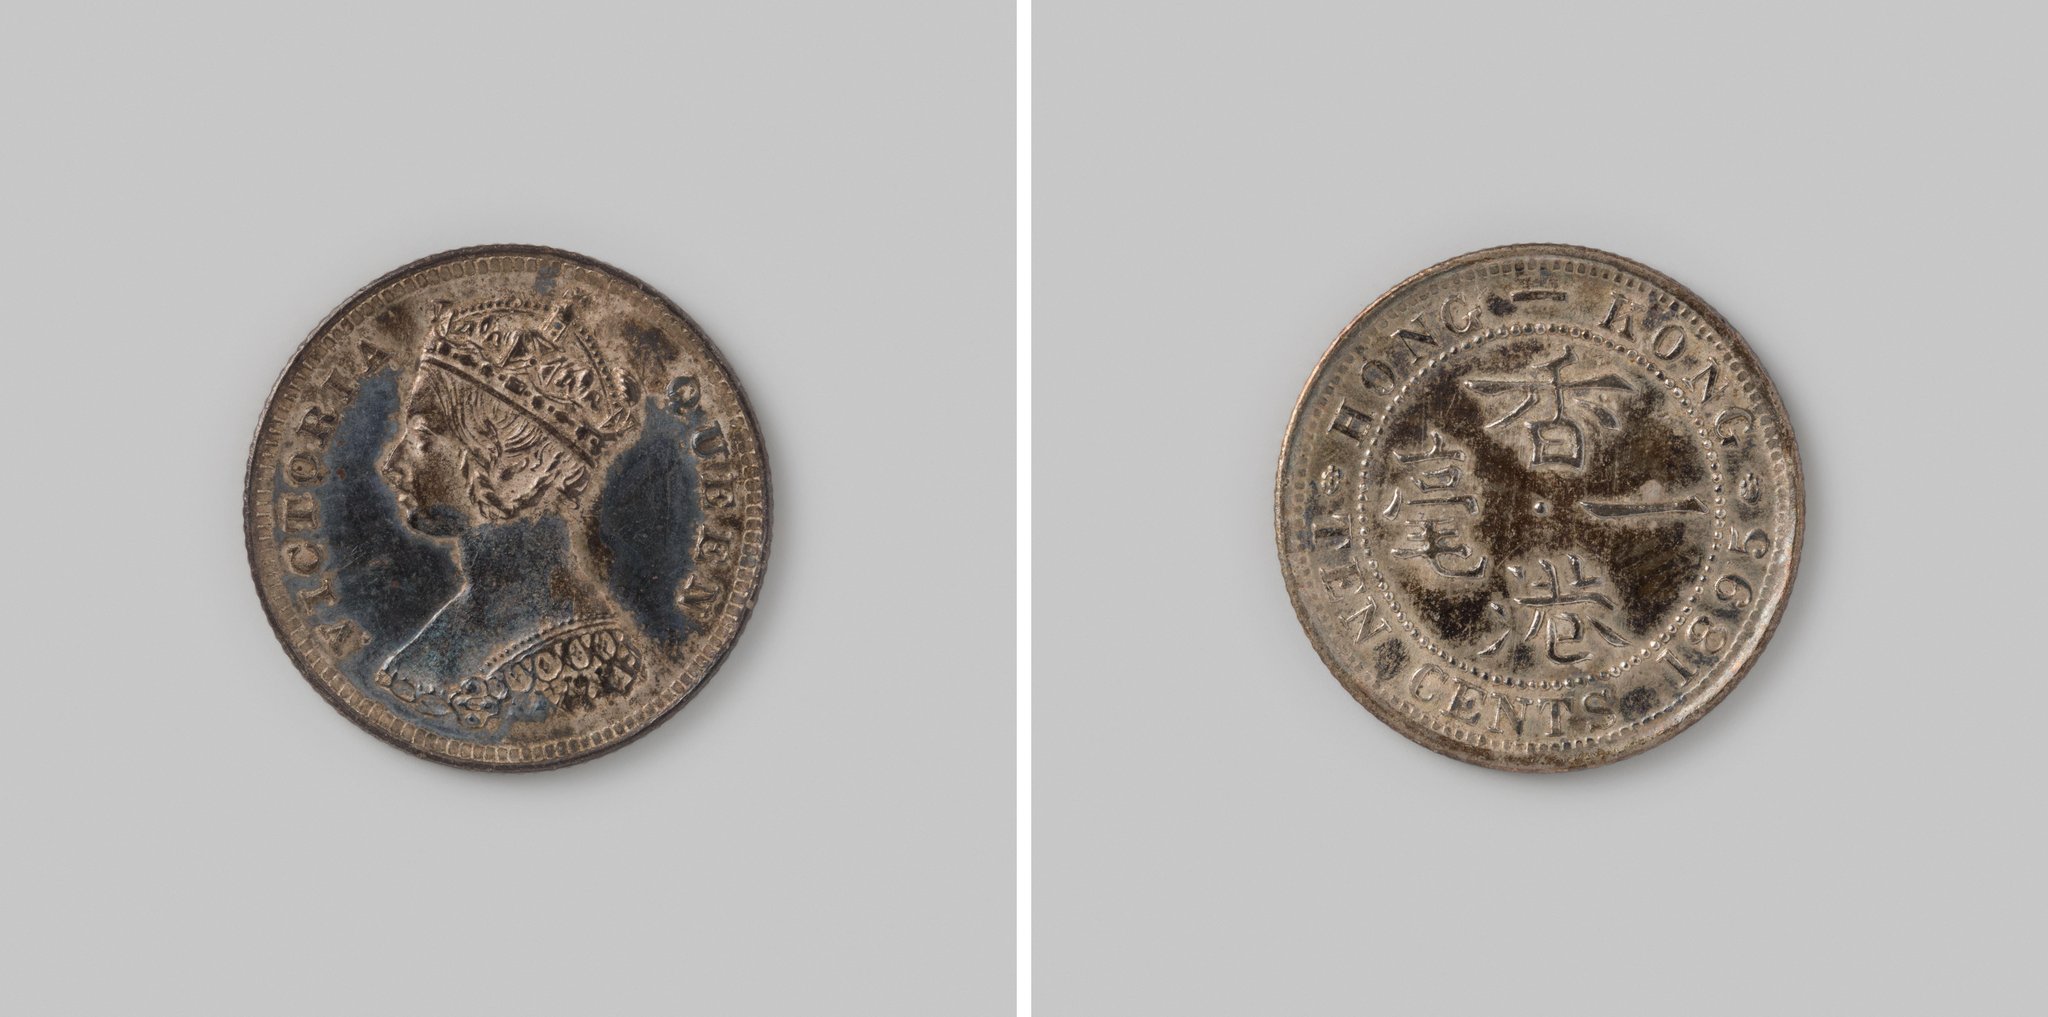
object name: coin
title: Hongkong, koningin Victoria, 10 cents, 1895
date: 1895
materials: silver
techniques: striking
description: Zilveren munt. Voorzijde: gekroond borstbeeld van de koningin naar links. Keerzijde: in het omschrift waarde-aanduiding: 10 cents met rechts daarvan jaartal. Kartelrand.